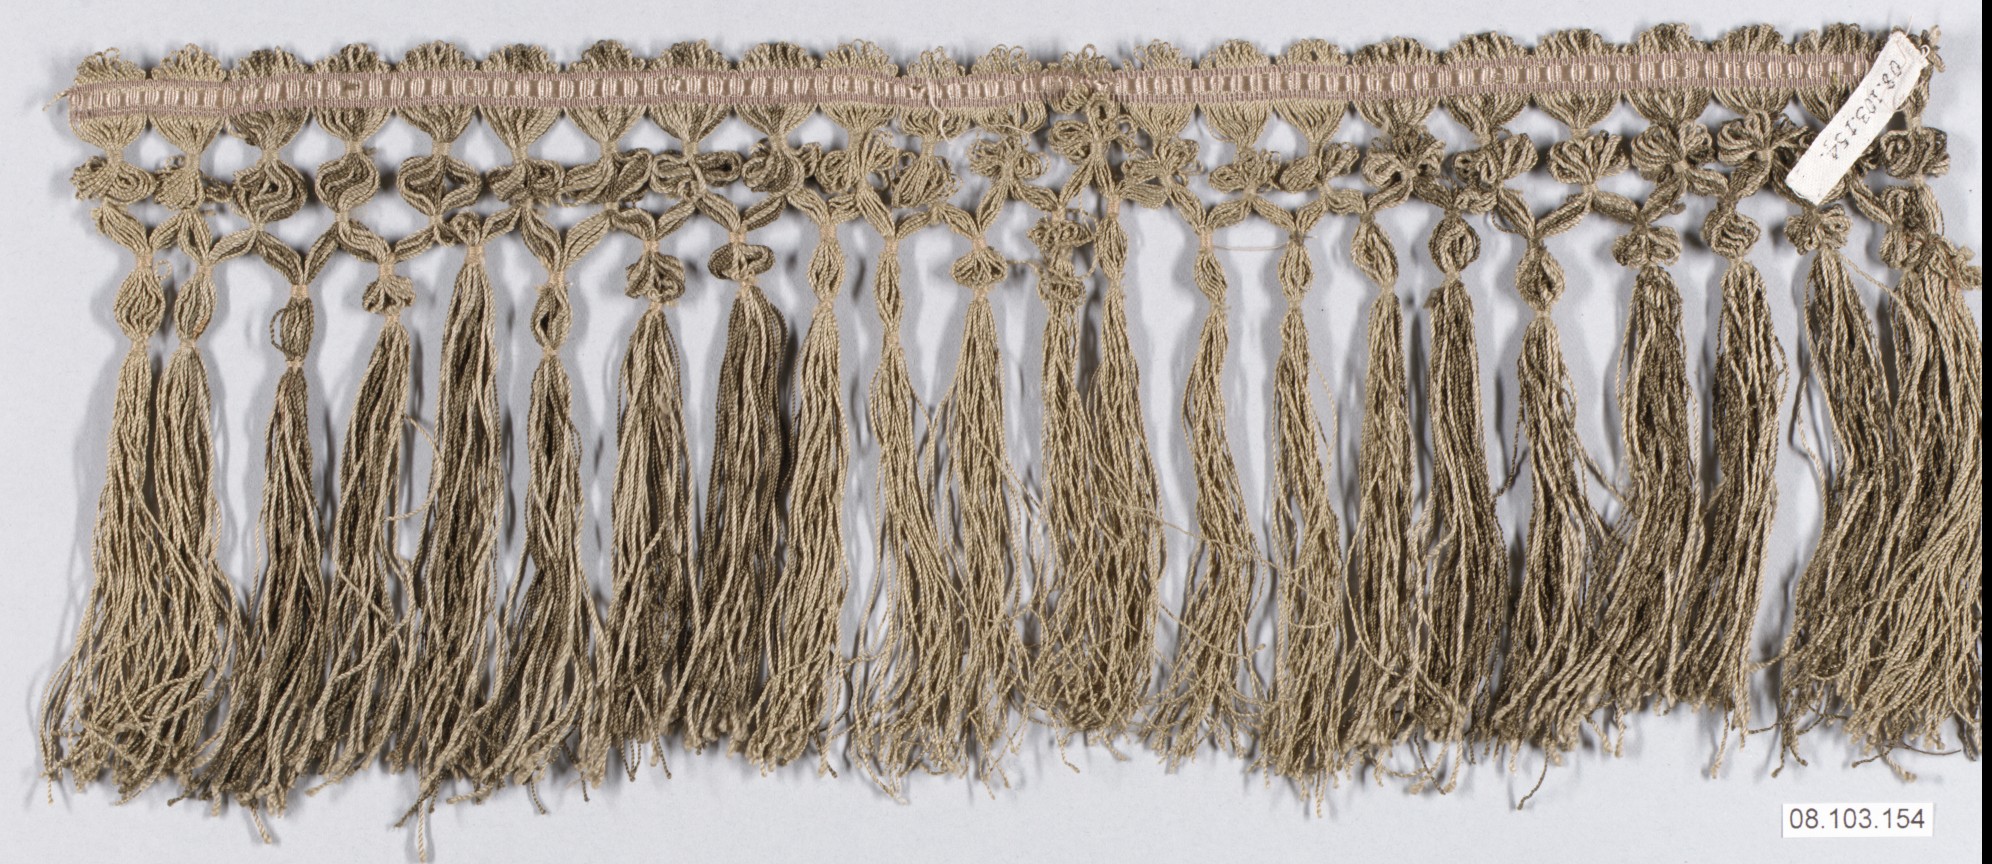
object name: fringe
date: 1801-1900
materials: silk